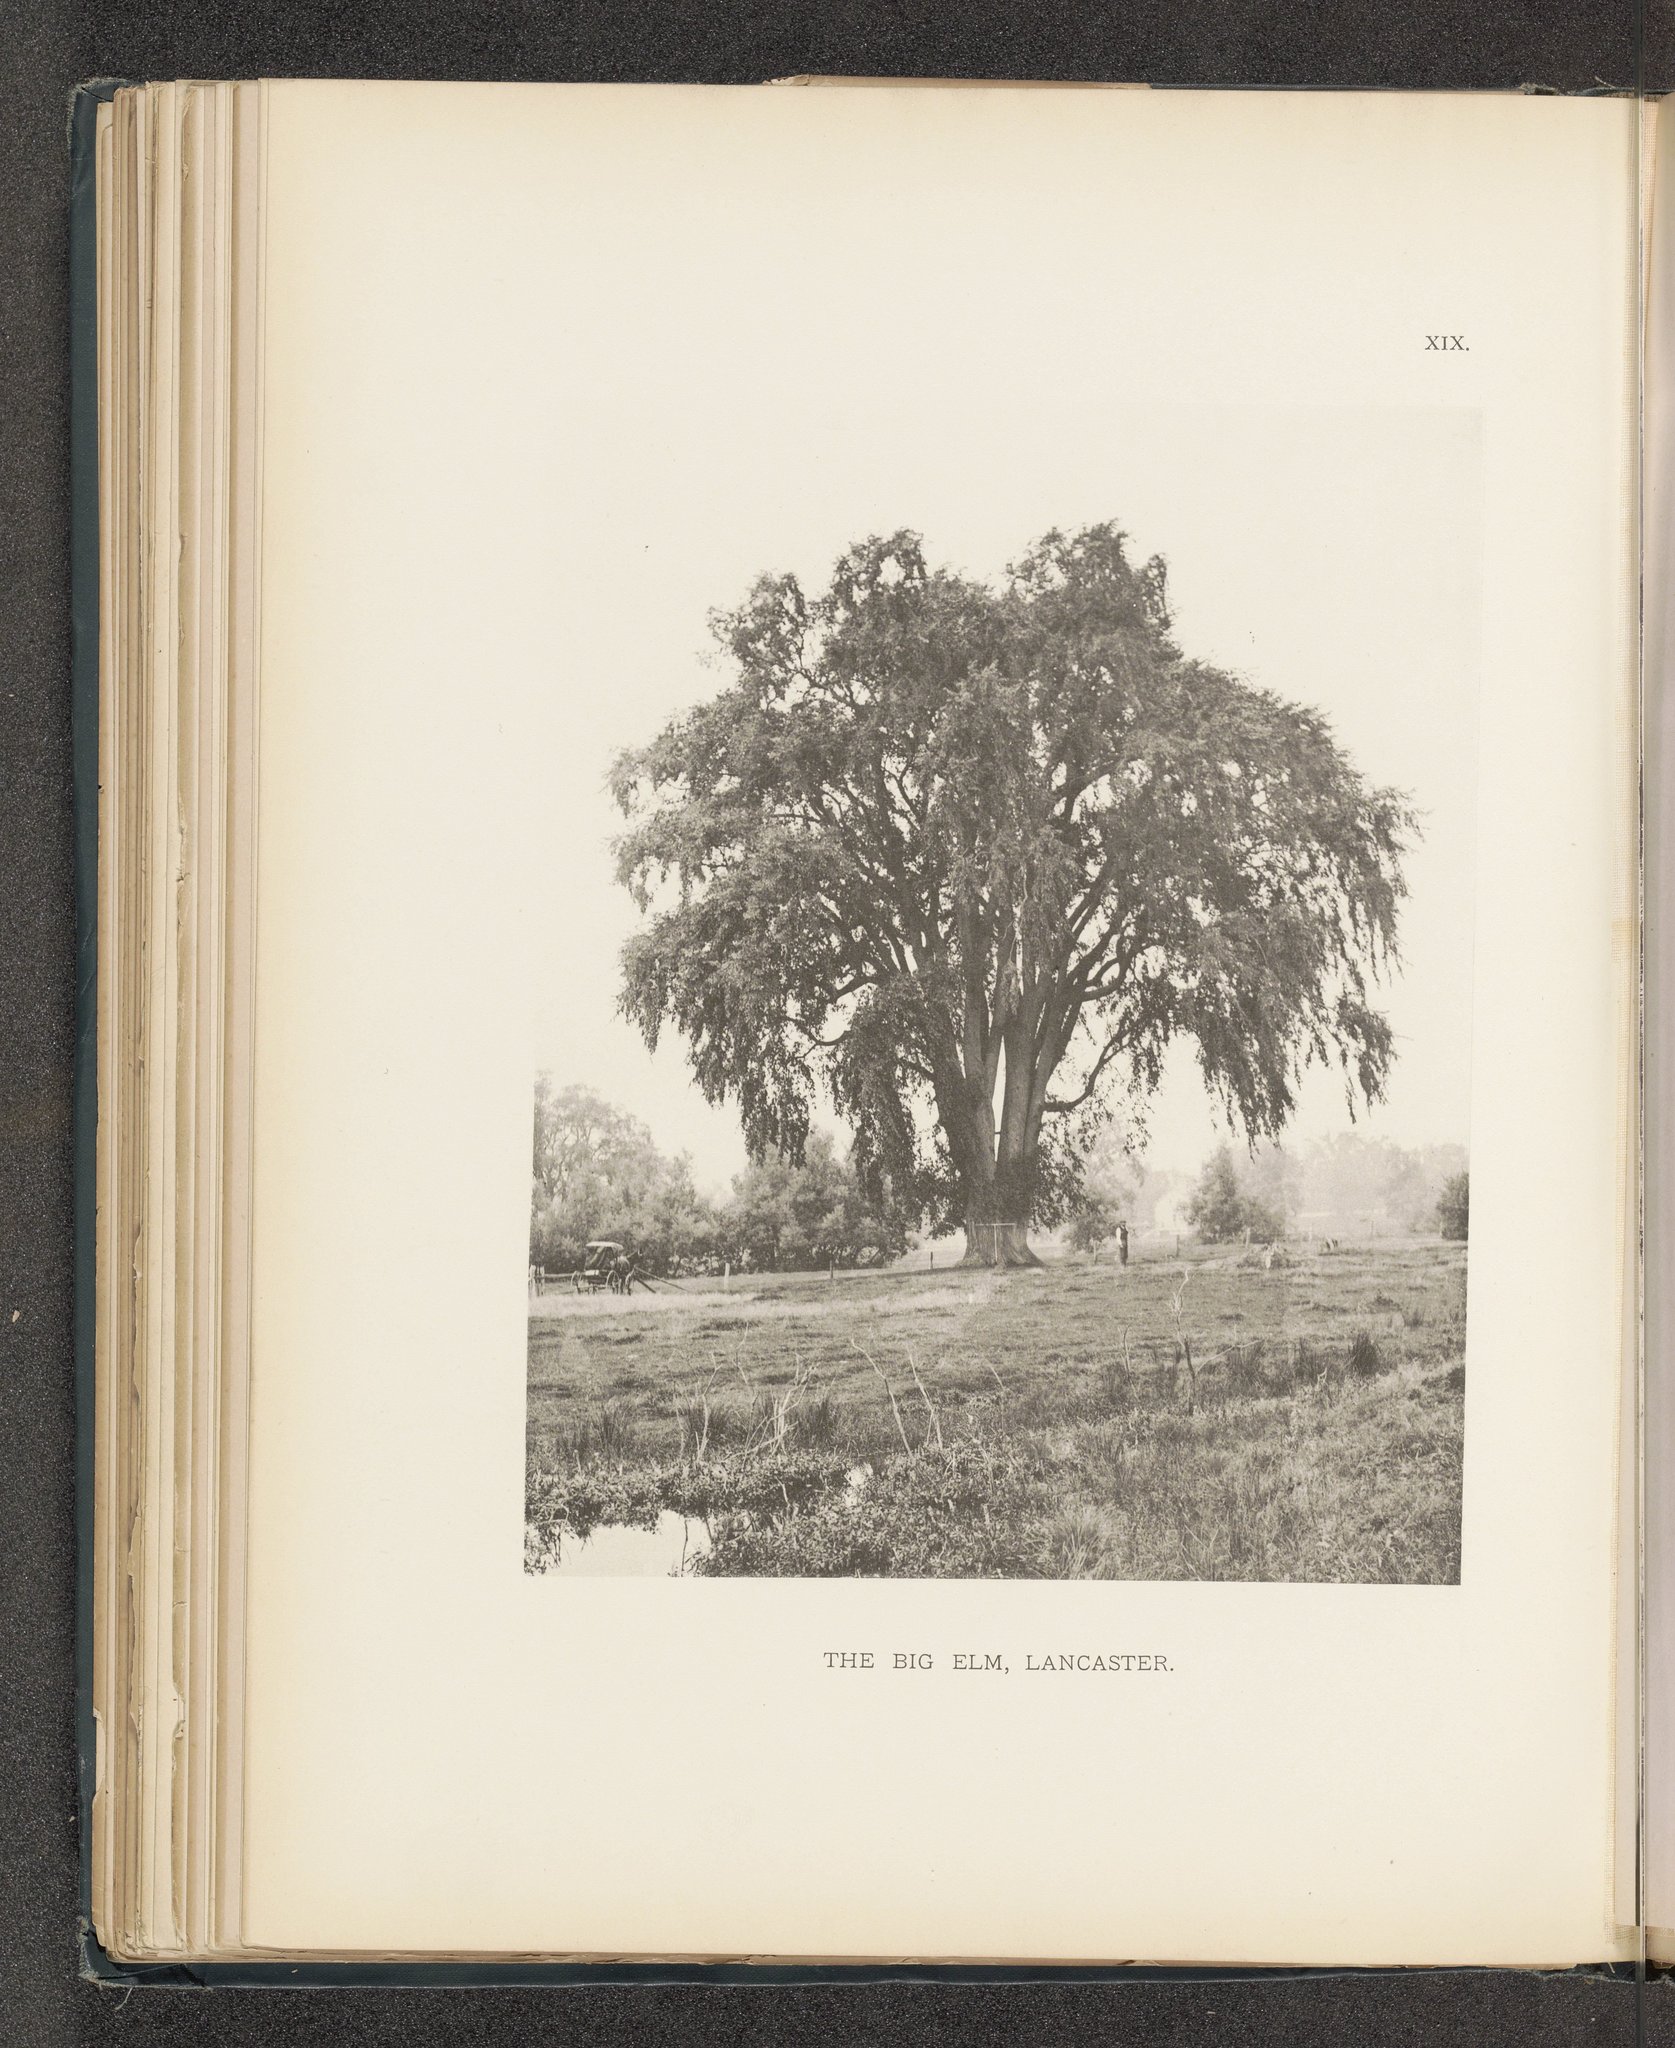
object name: page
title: The big elm, Lancaster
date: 1880-1890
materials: paper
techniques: photograph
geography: united states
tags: trees: elm, four-wheeled, animal-drawn vehicle, e.g.: cab, carriage, coach, meadow, pasture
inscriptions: number: ‘XIX.’